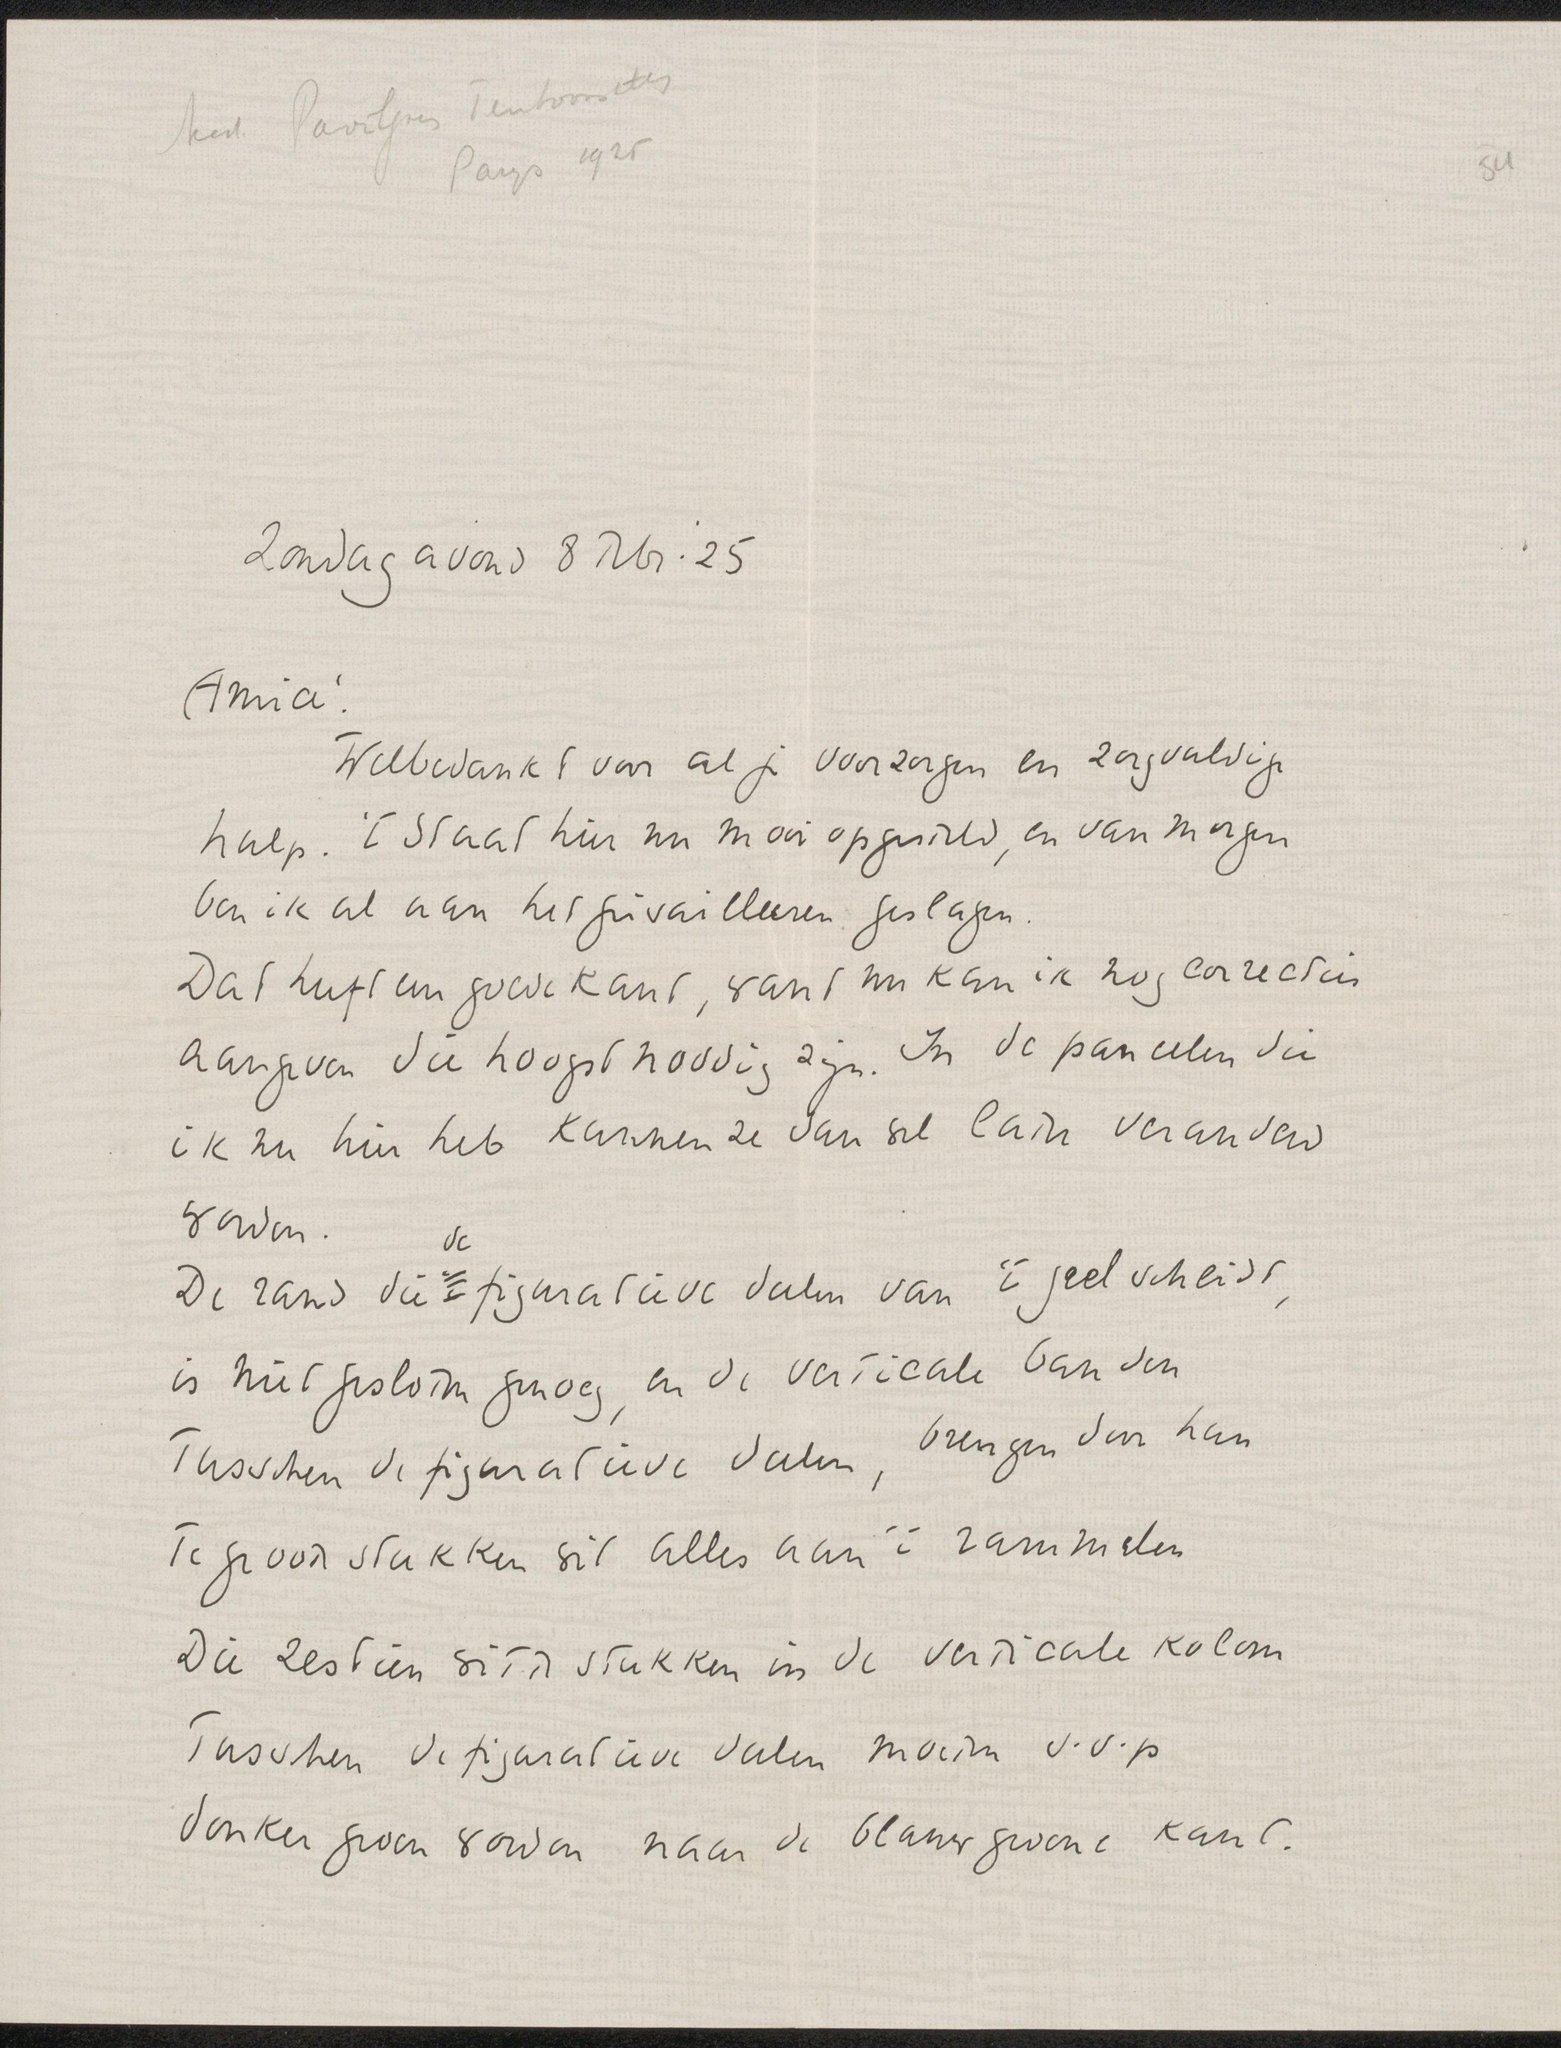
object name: letter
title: Brief aan Willem Bogtman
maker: richard nicolaüs roland holst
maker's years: 1868-1938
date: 1925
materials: ink, paper, pencil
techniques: pen, writing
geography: paris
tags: haarlem, willem bogtman, applied arts, arts and crafts; industrial design, plan ~ architecture, exhibition ~ art, paris